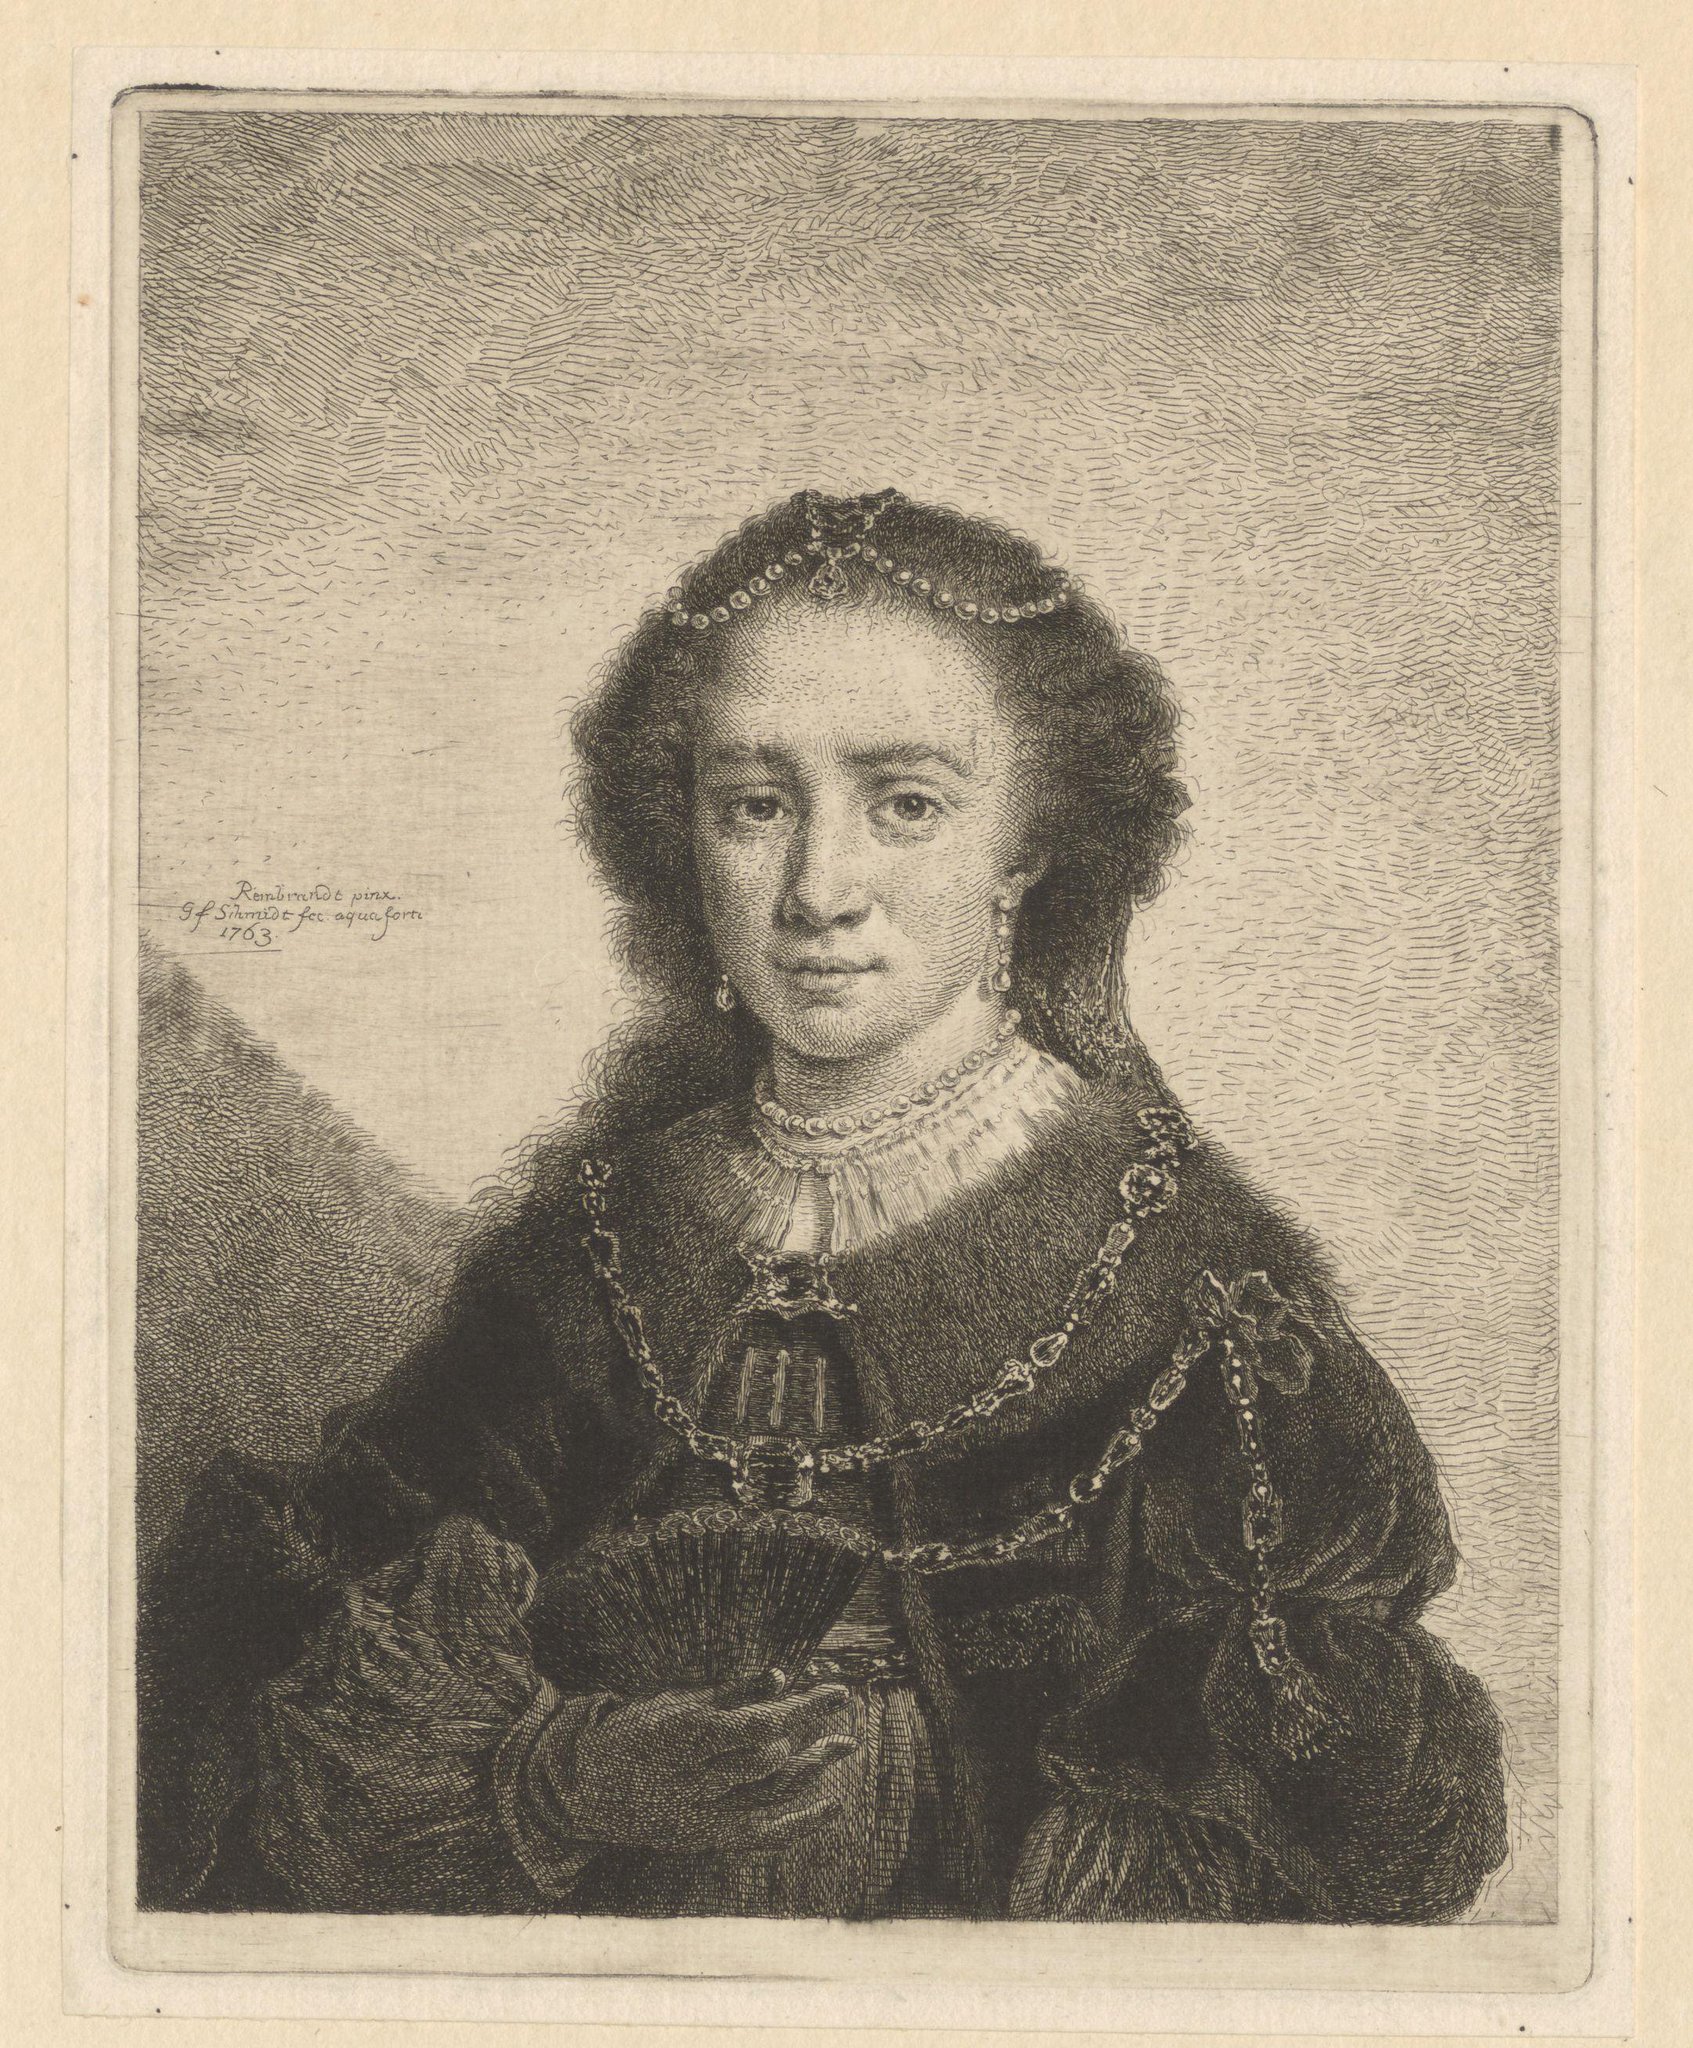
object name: print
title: Vrouw met waaier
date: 1763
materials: paper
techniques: etching, intaglio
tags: adult woman, fan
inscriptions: collector's mark: Lugt 240